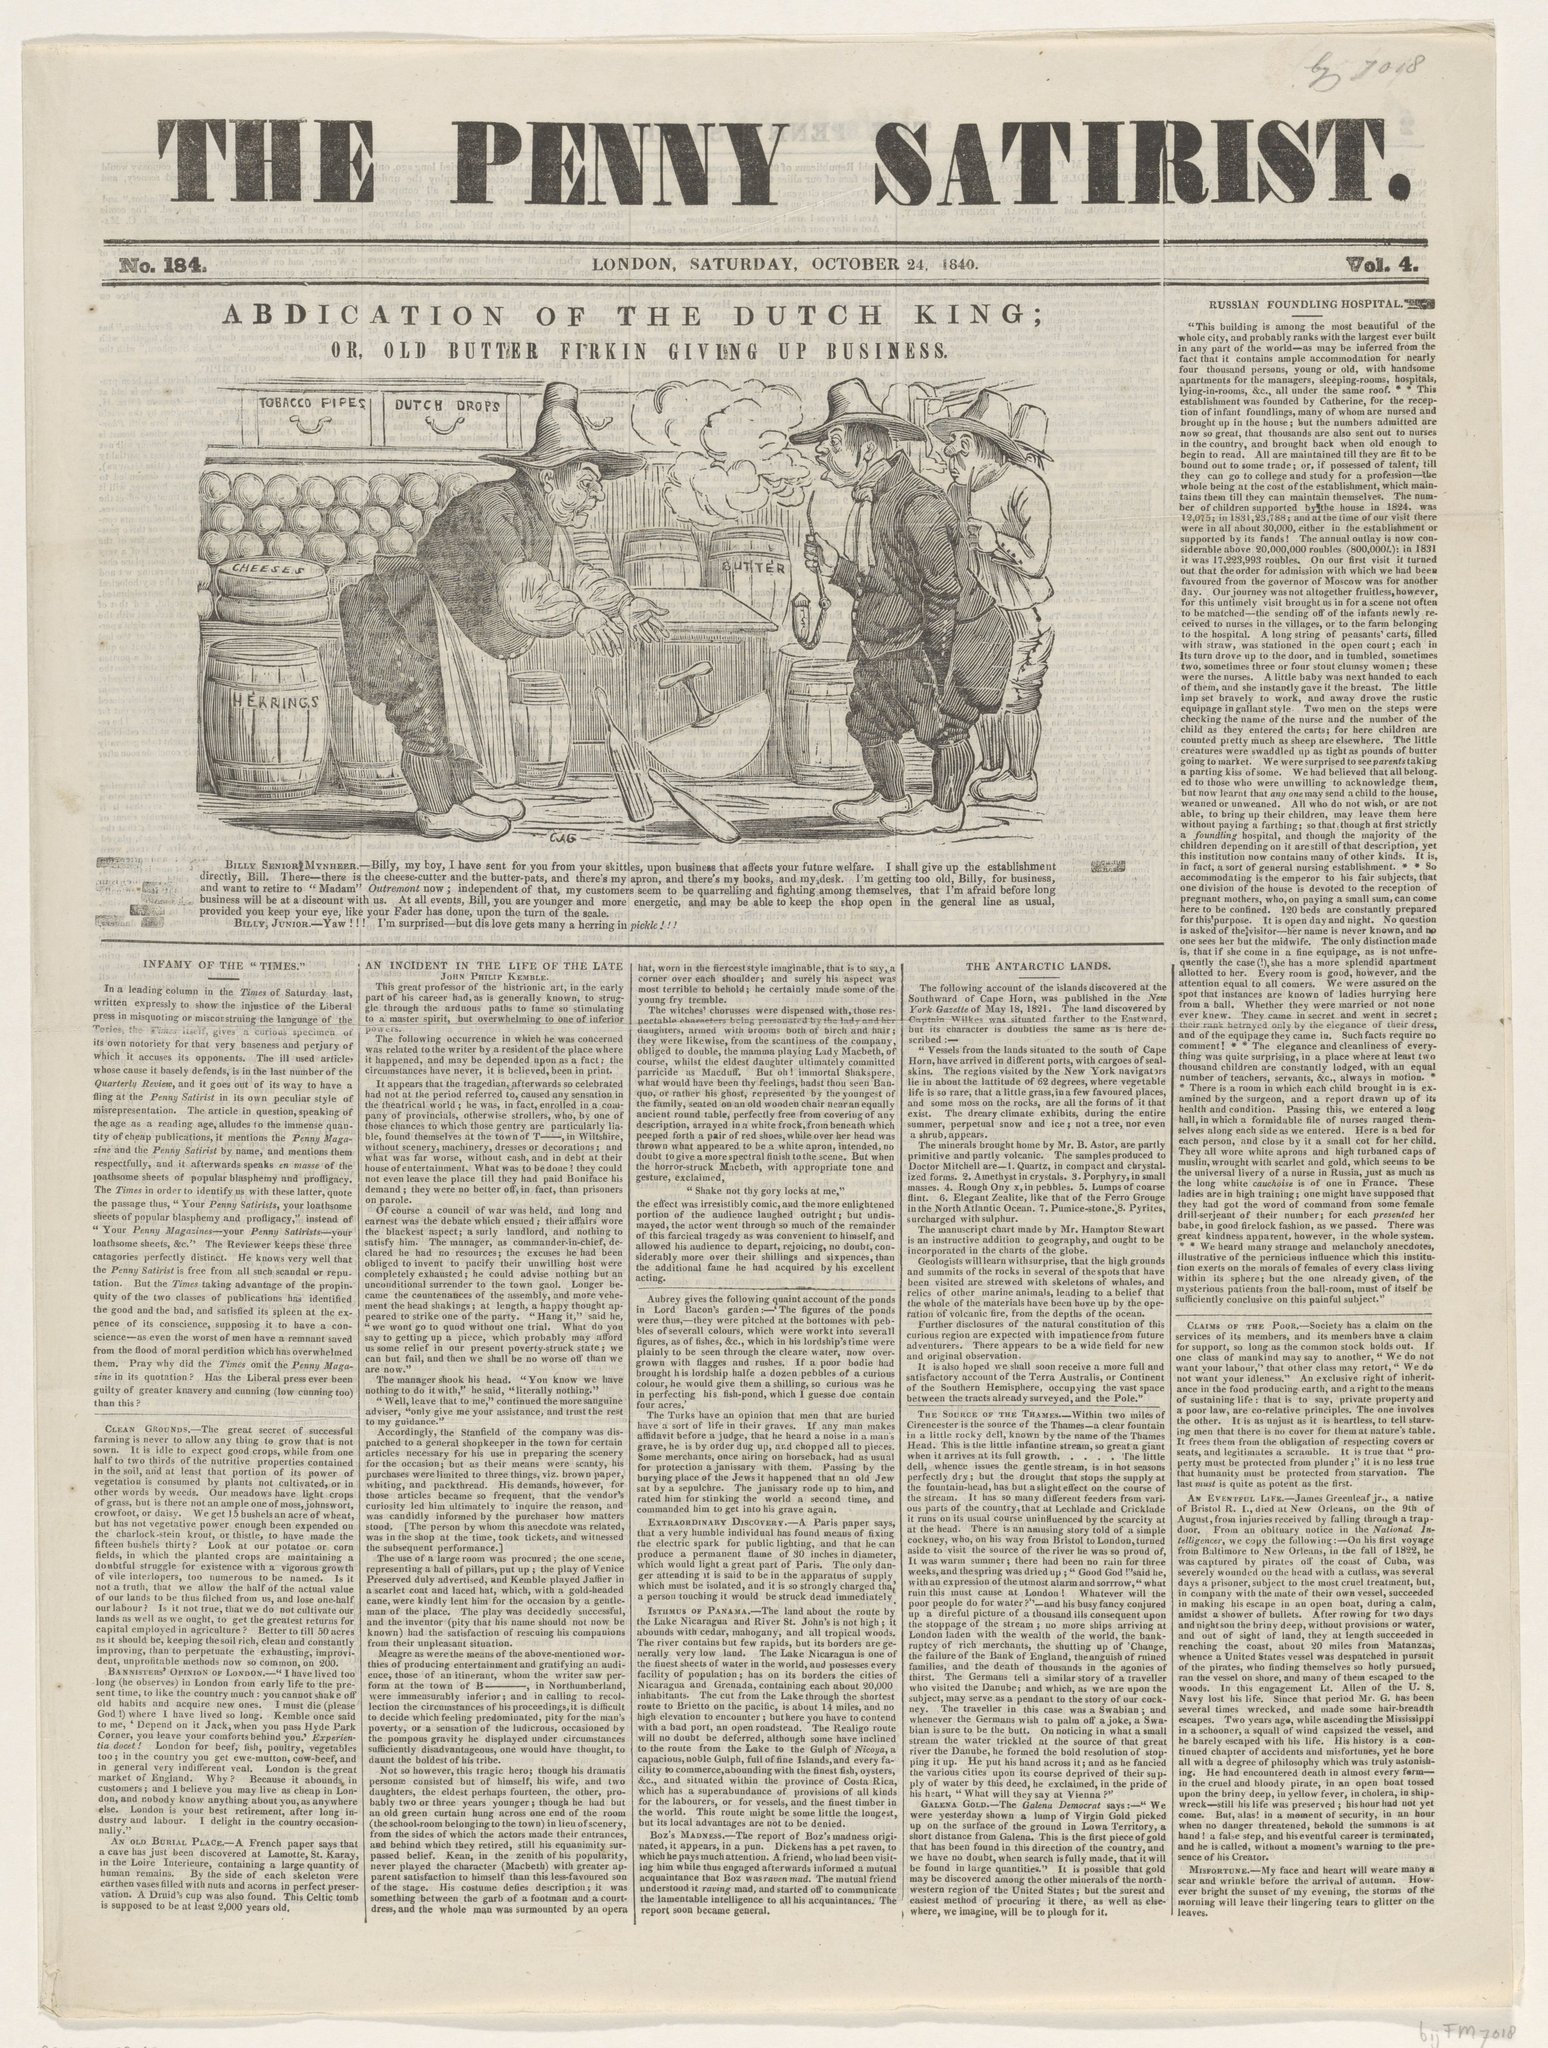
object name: cartoon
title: Spotprent op het voorgenomen huwelijk van de ex-koning Willem I, 1840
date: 1840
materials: paper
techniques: letterpress printing, engraving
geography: london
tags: the hague, berlin, william i of the netherlands, william ii of the netherlands, maastricht, shop, store, cheese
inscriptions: collector's mark: Lugt 2228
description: Exemplaar van het Engelse satirische blad 'The Penny Satirist' van 24 oktober 1840 met een spotprent van op de abdicatie van koning Willem I en zijn voorgenomen huwelijk met Henriëtte d'Oultremont de Wégimont. Willem I voorgesteld als een kaasboer die stopt met werken om te kunnen trouwen en de zaak overdraagt aan zijn zoon. De handeling speelt zich af in een winkel met vaten met haring en boter en stapels kazen. Willem I gooit het kaasmes op de grond voor de verbaasde pijprokende Willem II. In het onderschrift het gesprek tussen 'Billy Senior' en 'Billy Junior'. Dubbelgevouwen blad bedrukt op vier zijden.